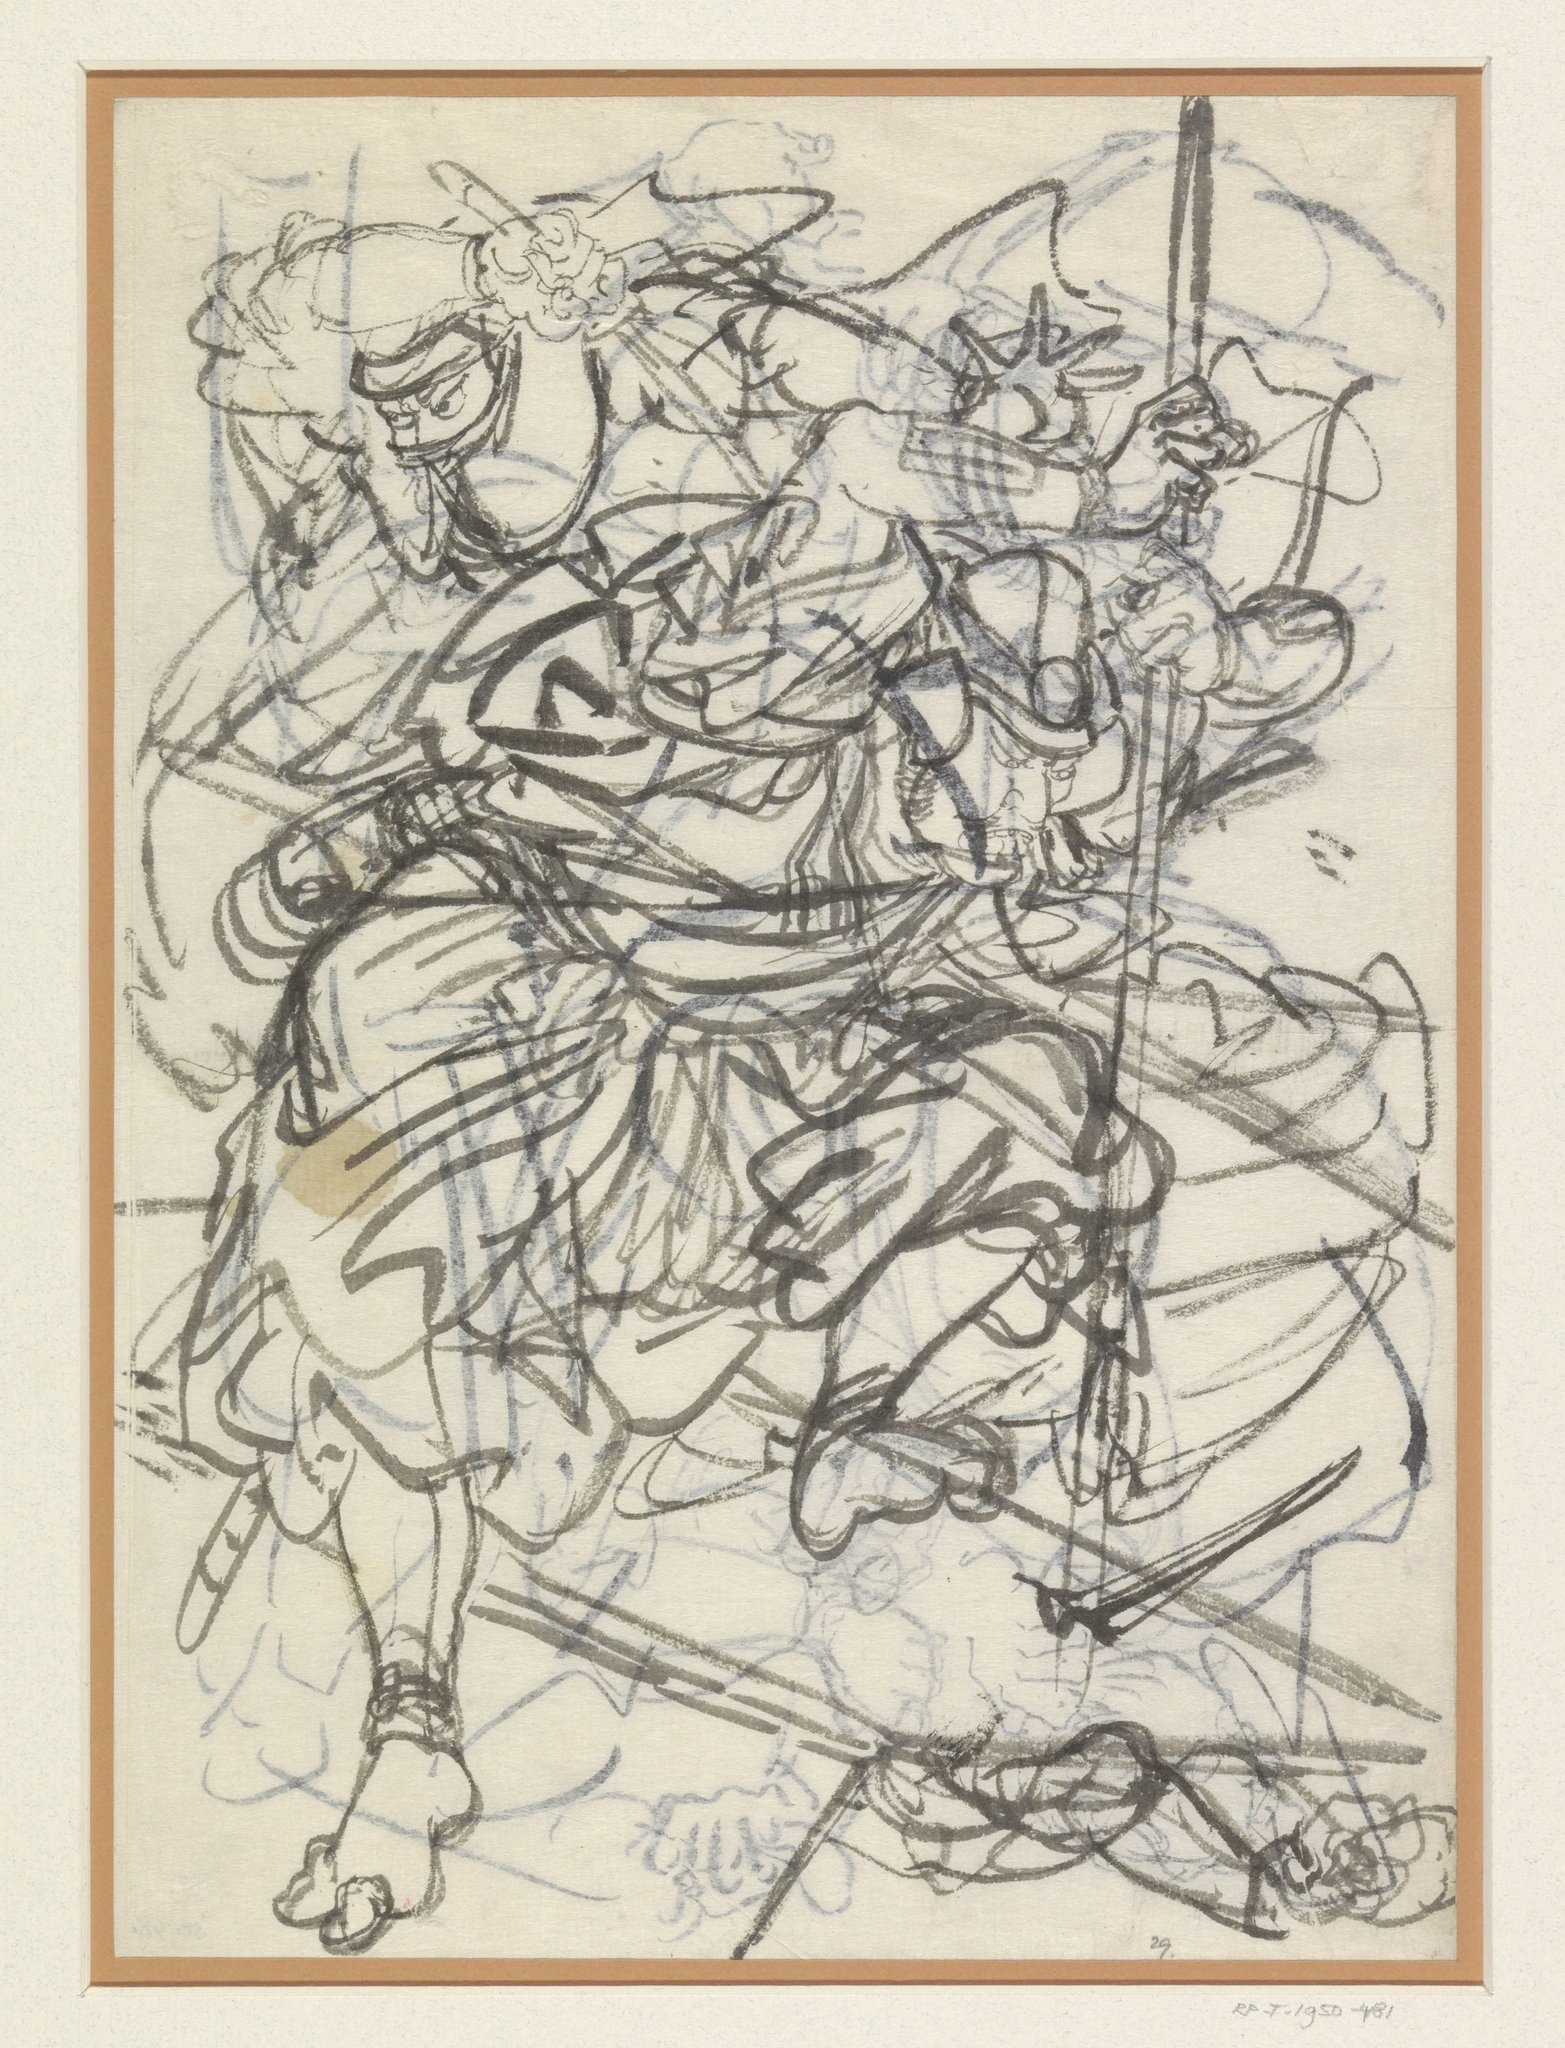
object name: drawing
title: Twee mannen in krijgsdans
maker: utagawa kuniyoshi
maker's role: draughtsman, print maker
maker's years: 1798-1861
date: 1808-1861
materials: paper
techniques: brush